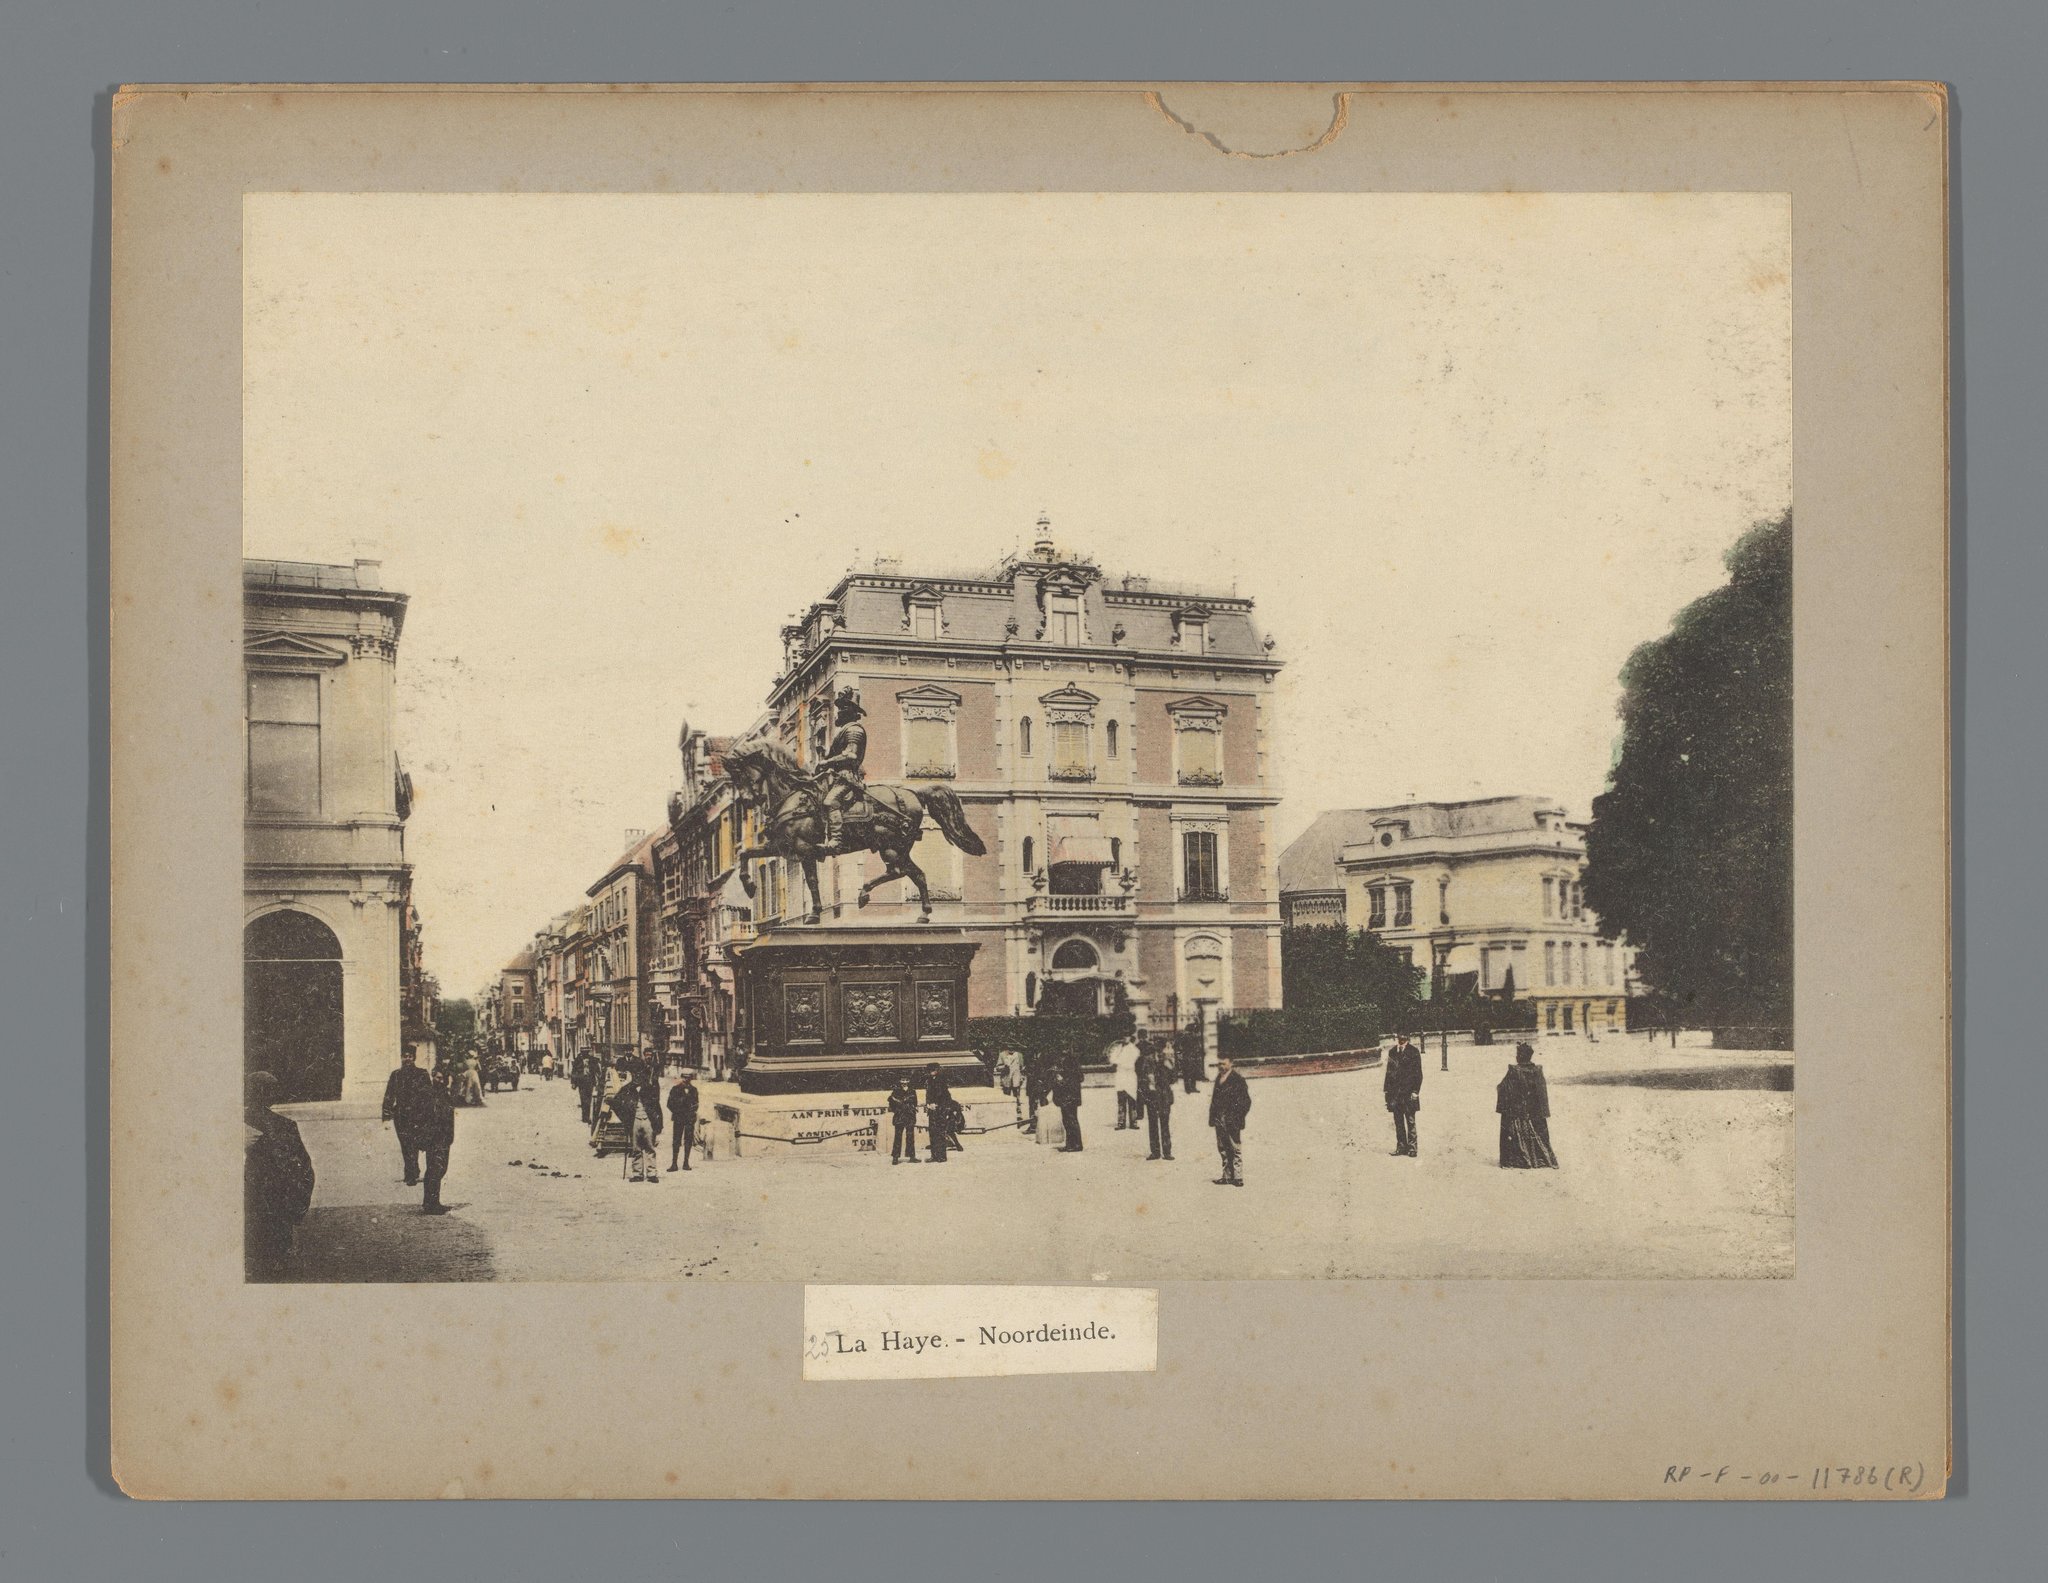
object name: photomechanical print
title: Standbeeld van Willem van Oranje aan het Noordeinde, Den Haag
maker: Anonymous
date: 1883-1910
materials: cardboard, paper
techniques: photograph, hand coloring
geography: the hague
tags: square, place, circus, etc., equestrian statue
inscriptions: number: ‘25’